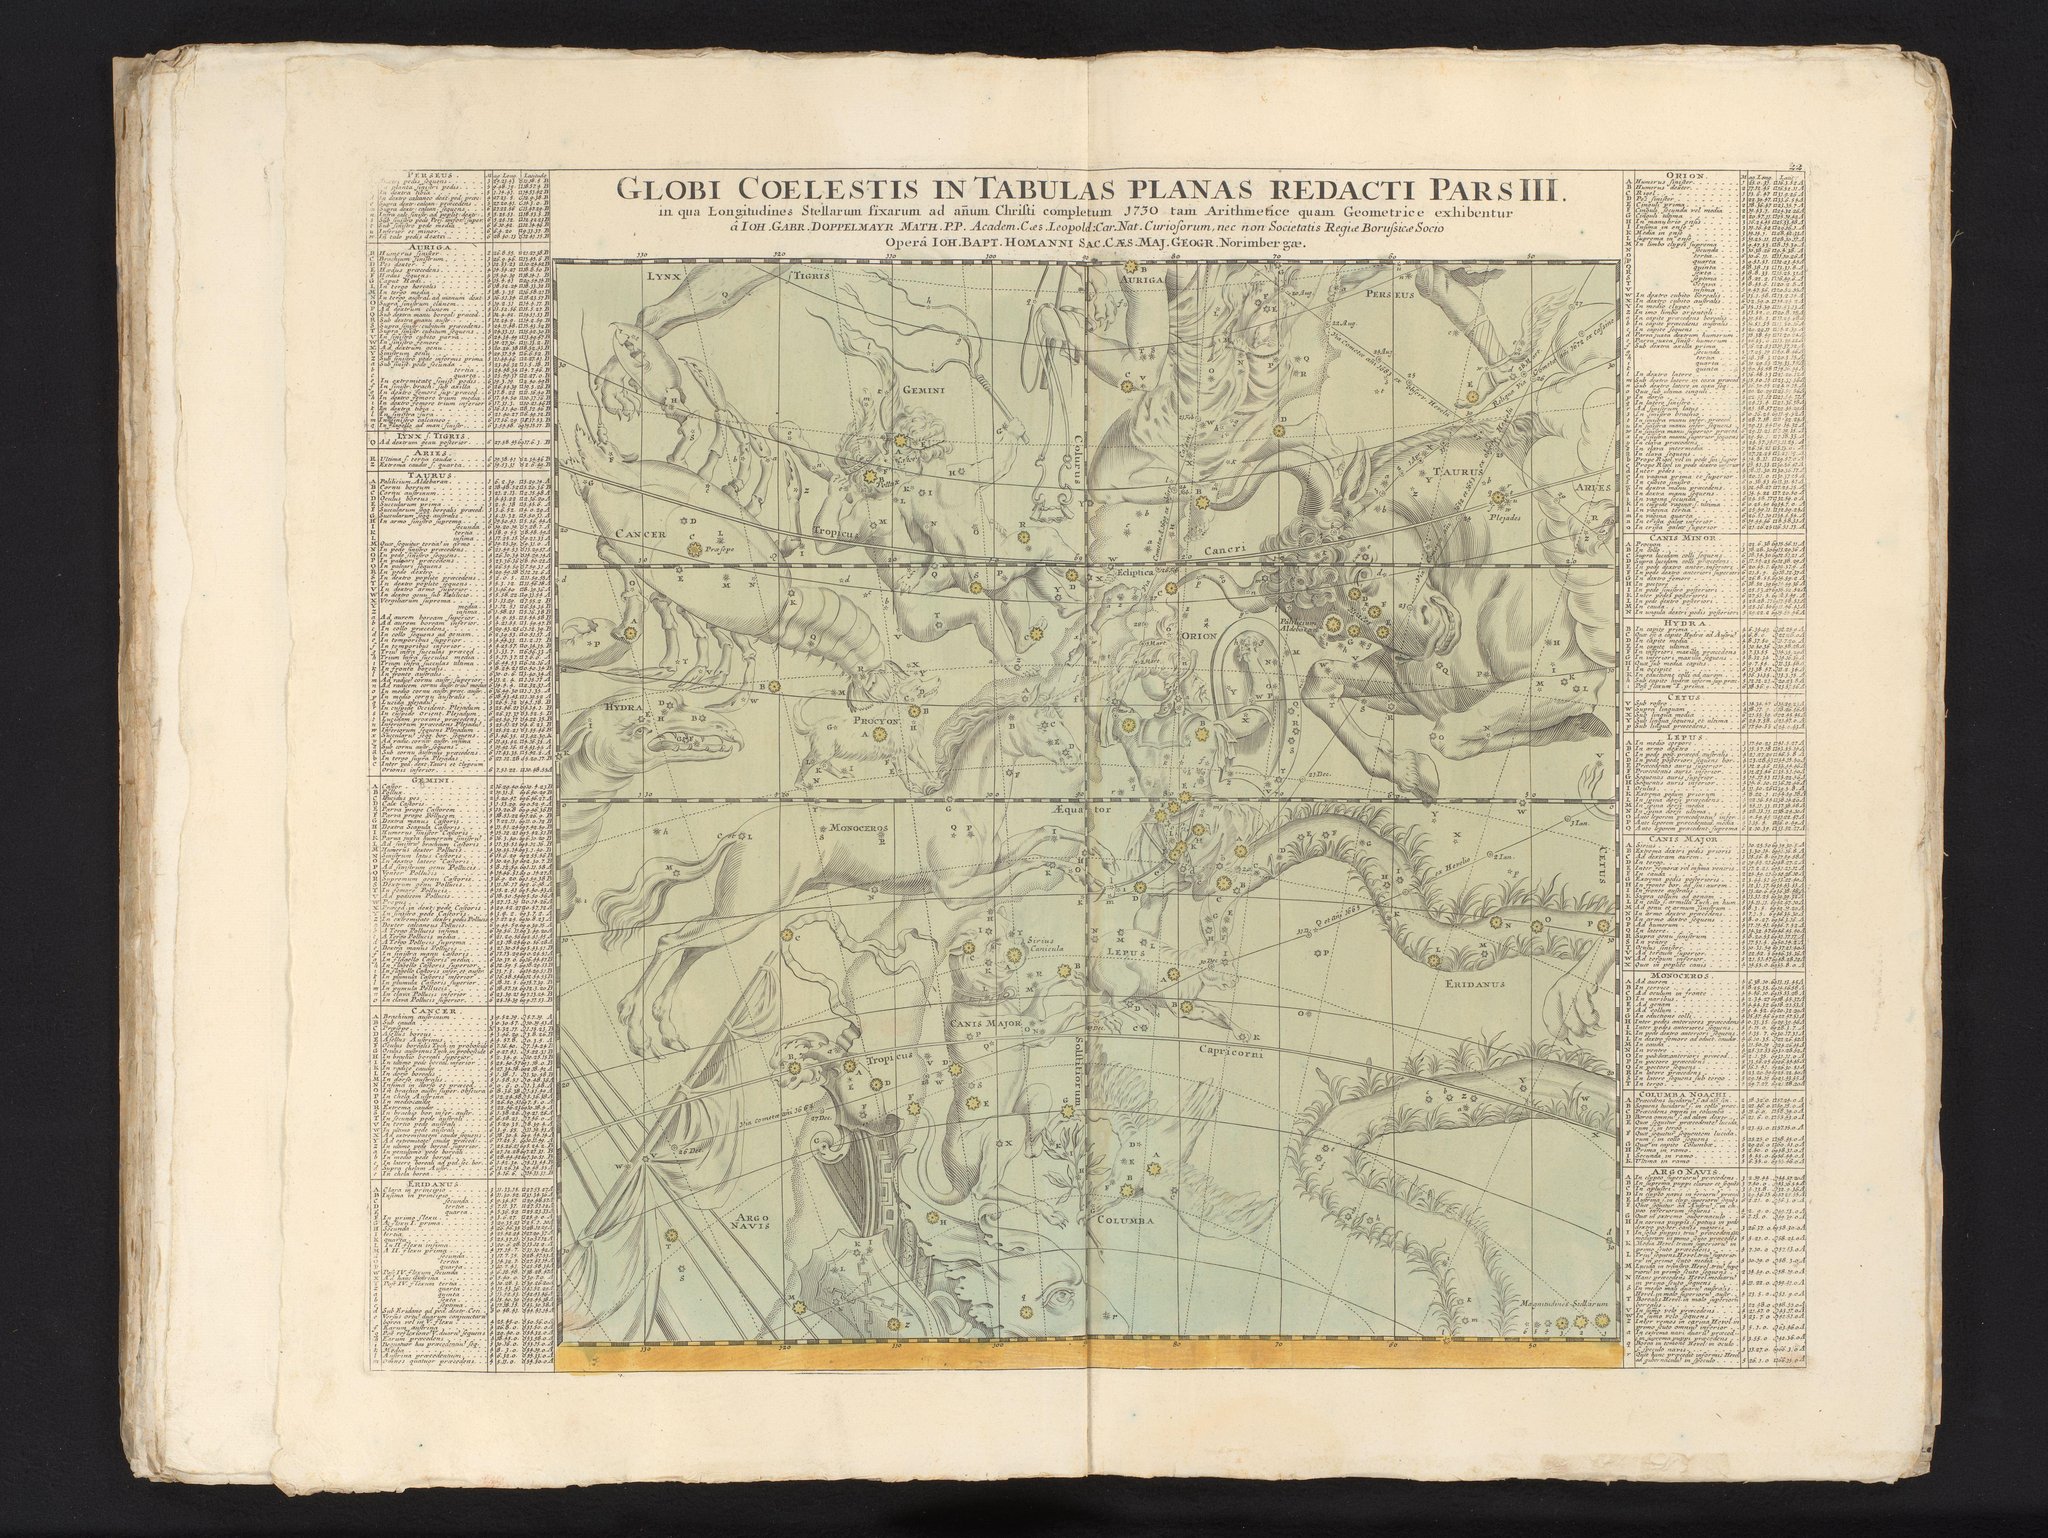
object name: print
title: Derde deel van een zesdelige reeks kaarten van de sterrenhemel aan het eind van het jaar 1730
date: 1742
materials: paper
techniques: engraving, etching, hand coloring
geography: nuremberg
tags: zodiac; the twelve zodiacal signs together, star-chart, star map